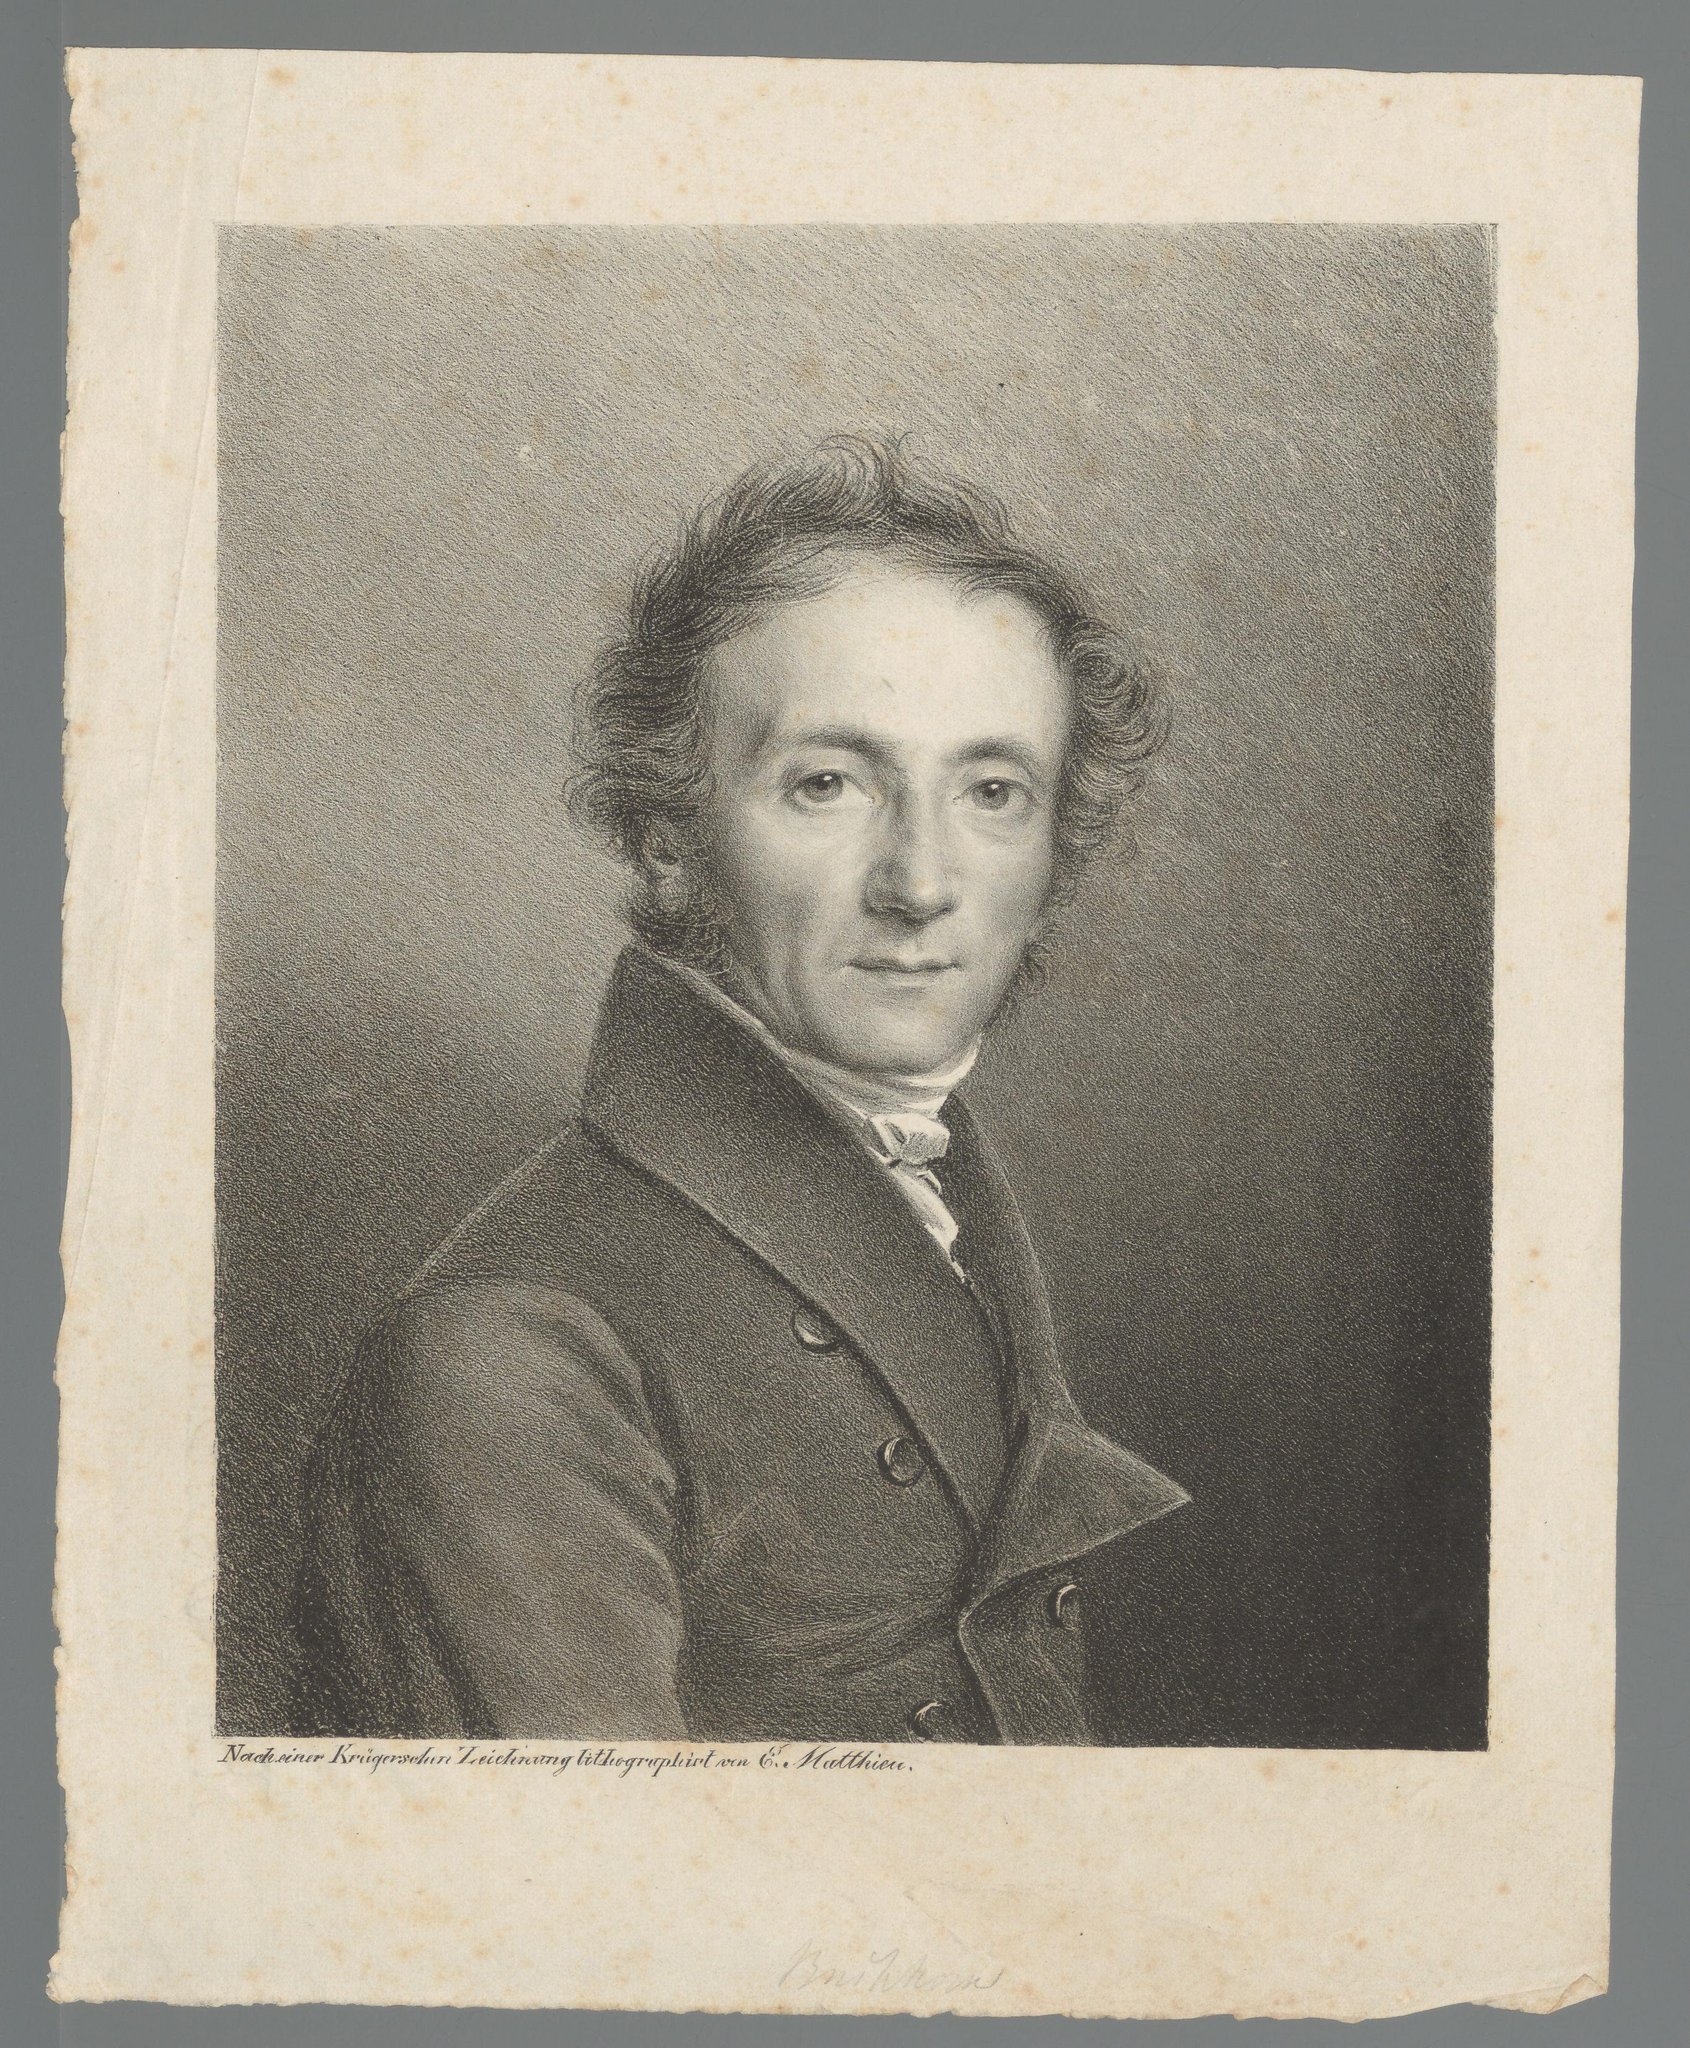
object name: print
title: Portret van Ludwig Buchhorn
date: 1800-1860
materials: paper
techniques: lithograph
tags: berlin, painter, print maker, ludwig buchhorn, historical persons, portrait, self-portrait of graphic artist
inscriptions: collector's mark: Lugt 2228